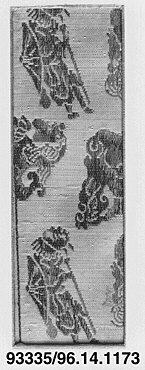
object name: piece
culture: japanese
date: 1701-1900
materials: silk